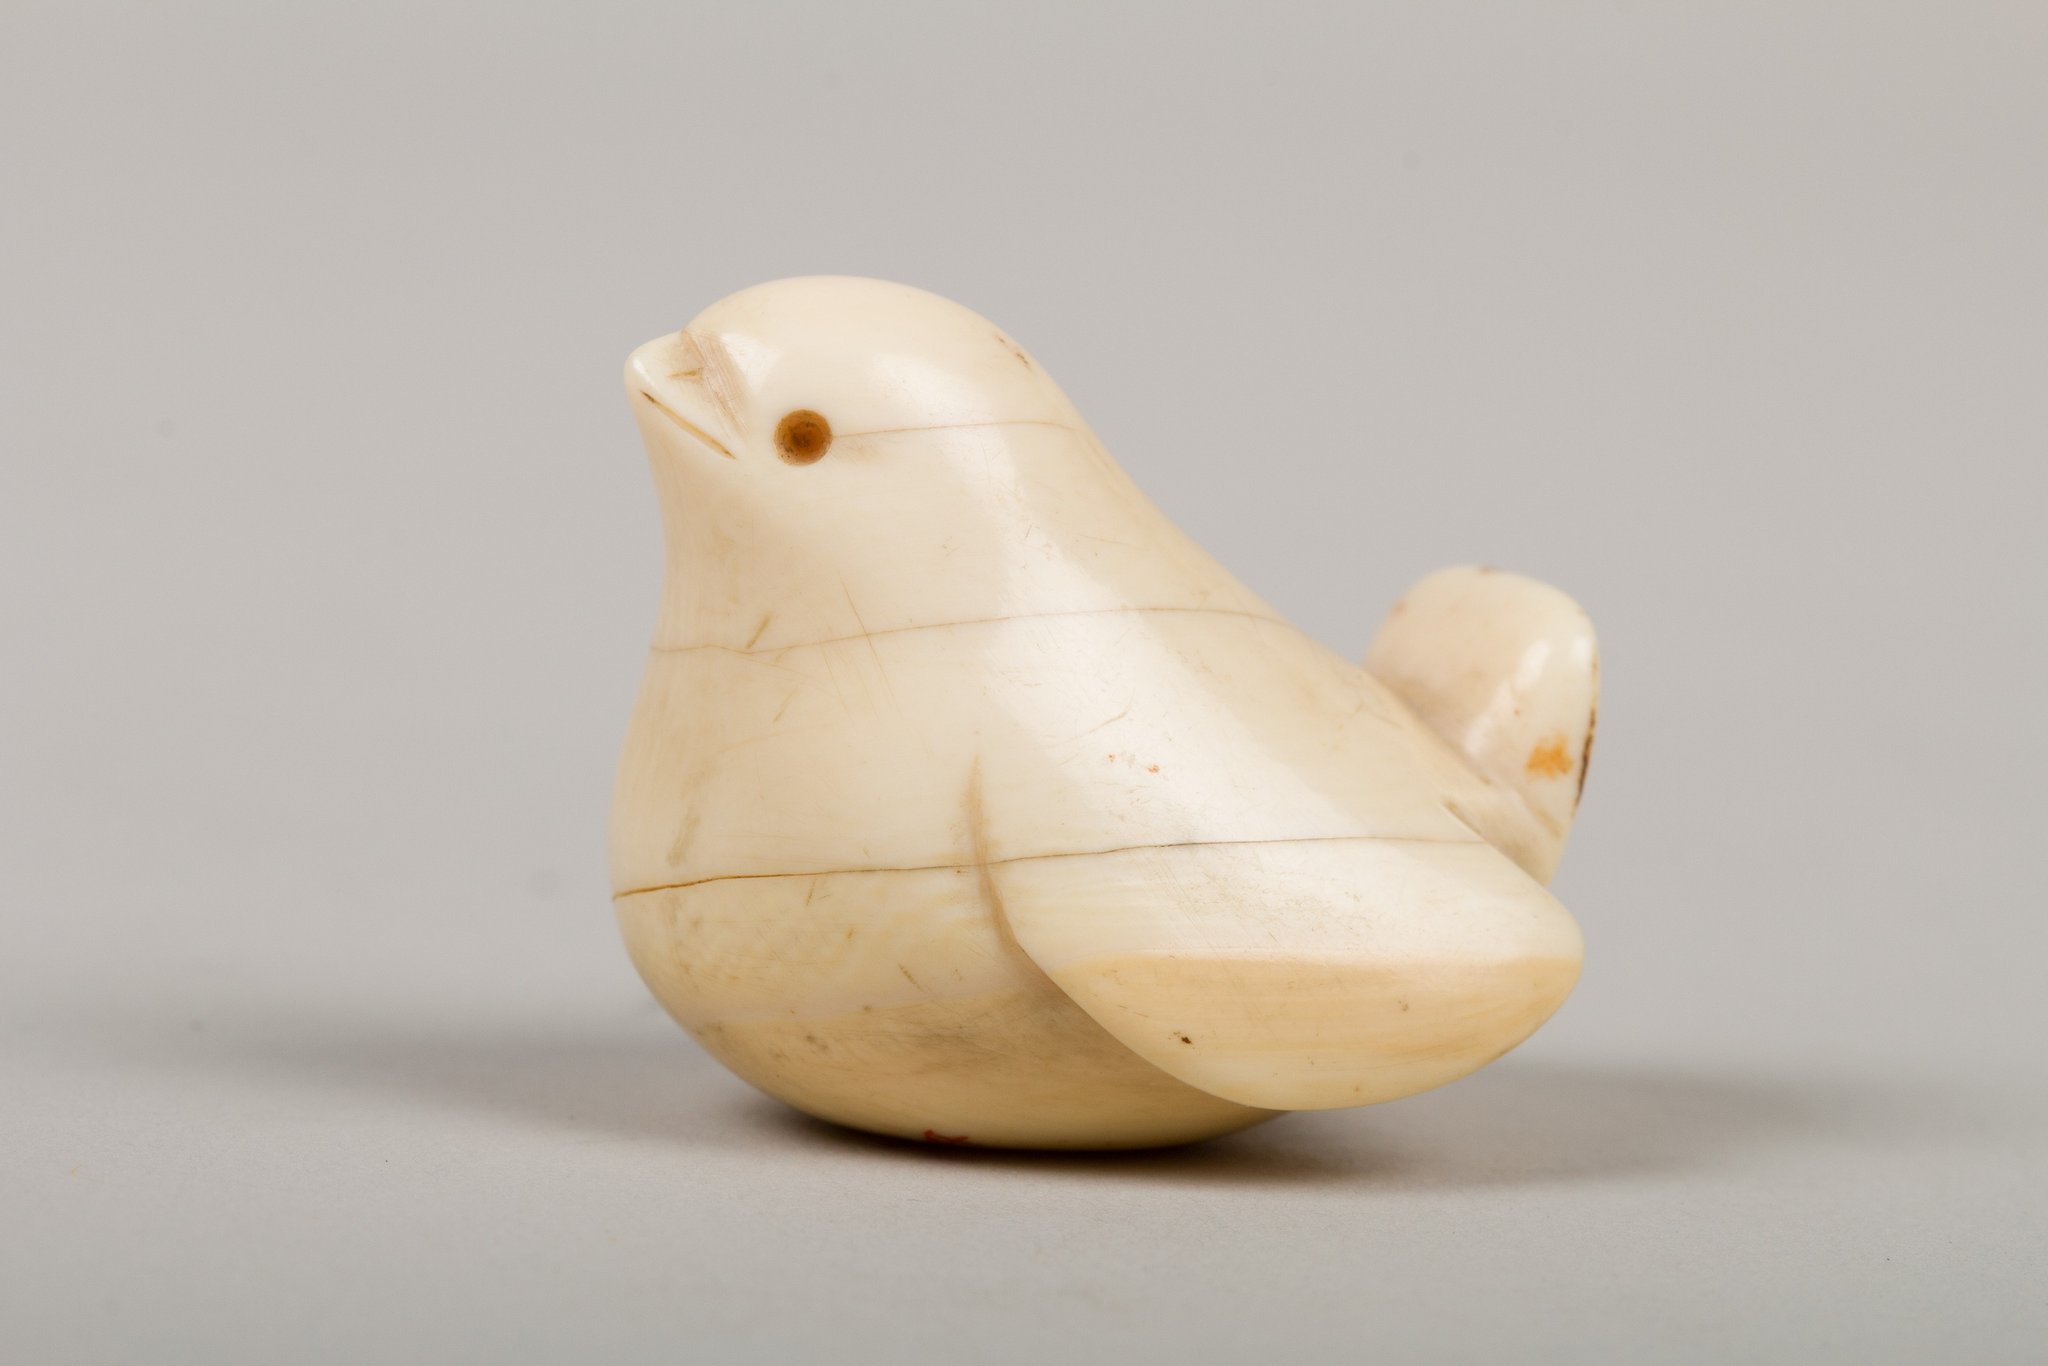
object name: netsuke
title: Netsuke of Bird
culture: japanese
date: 1801-1900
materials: ivory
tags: birds